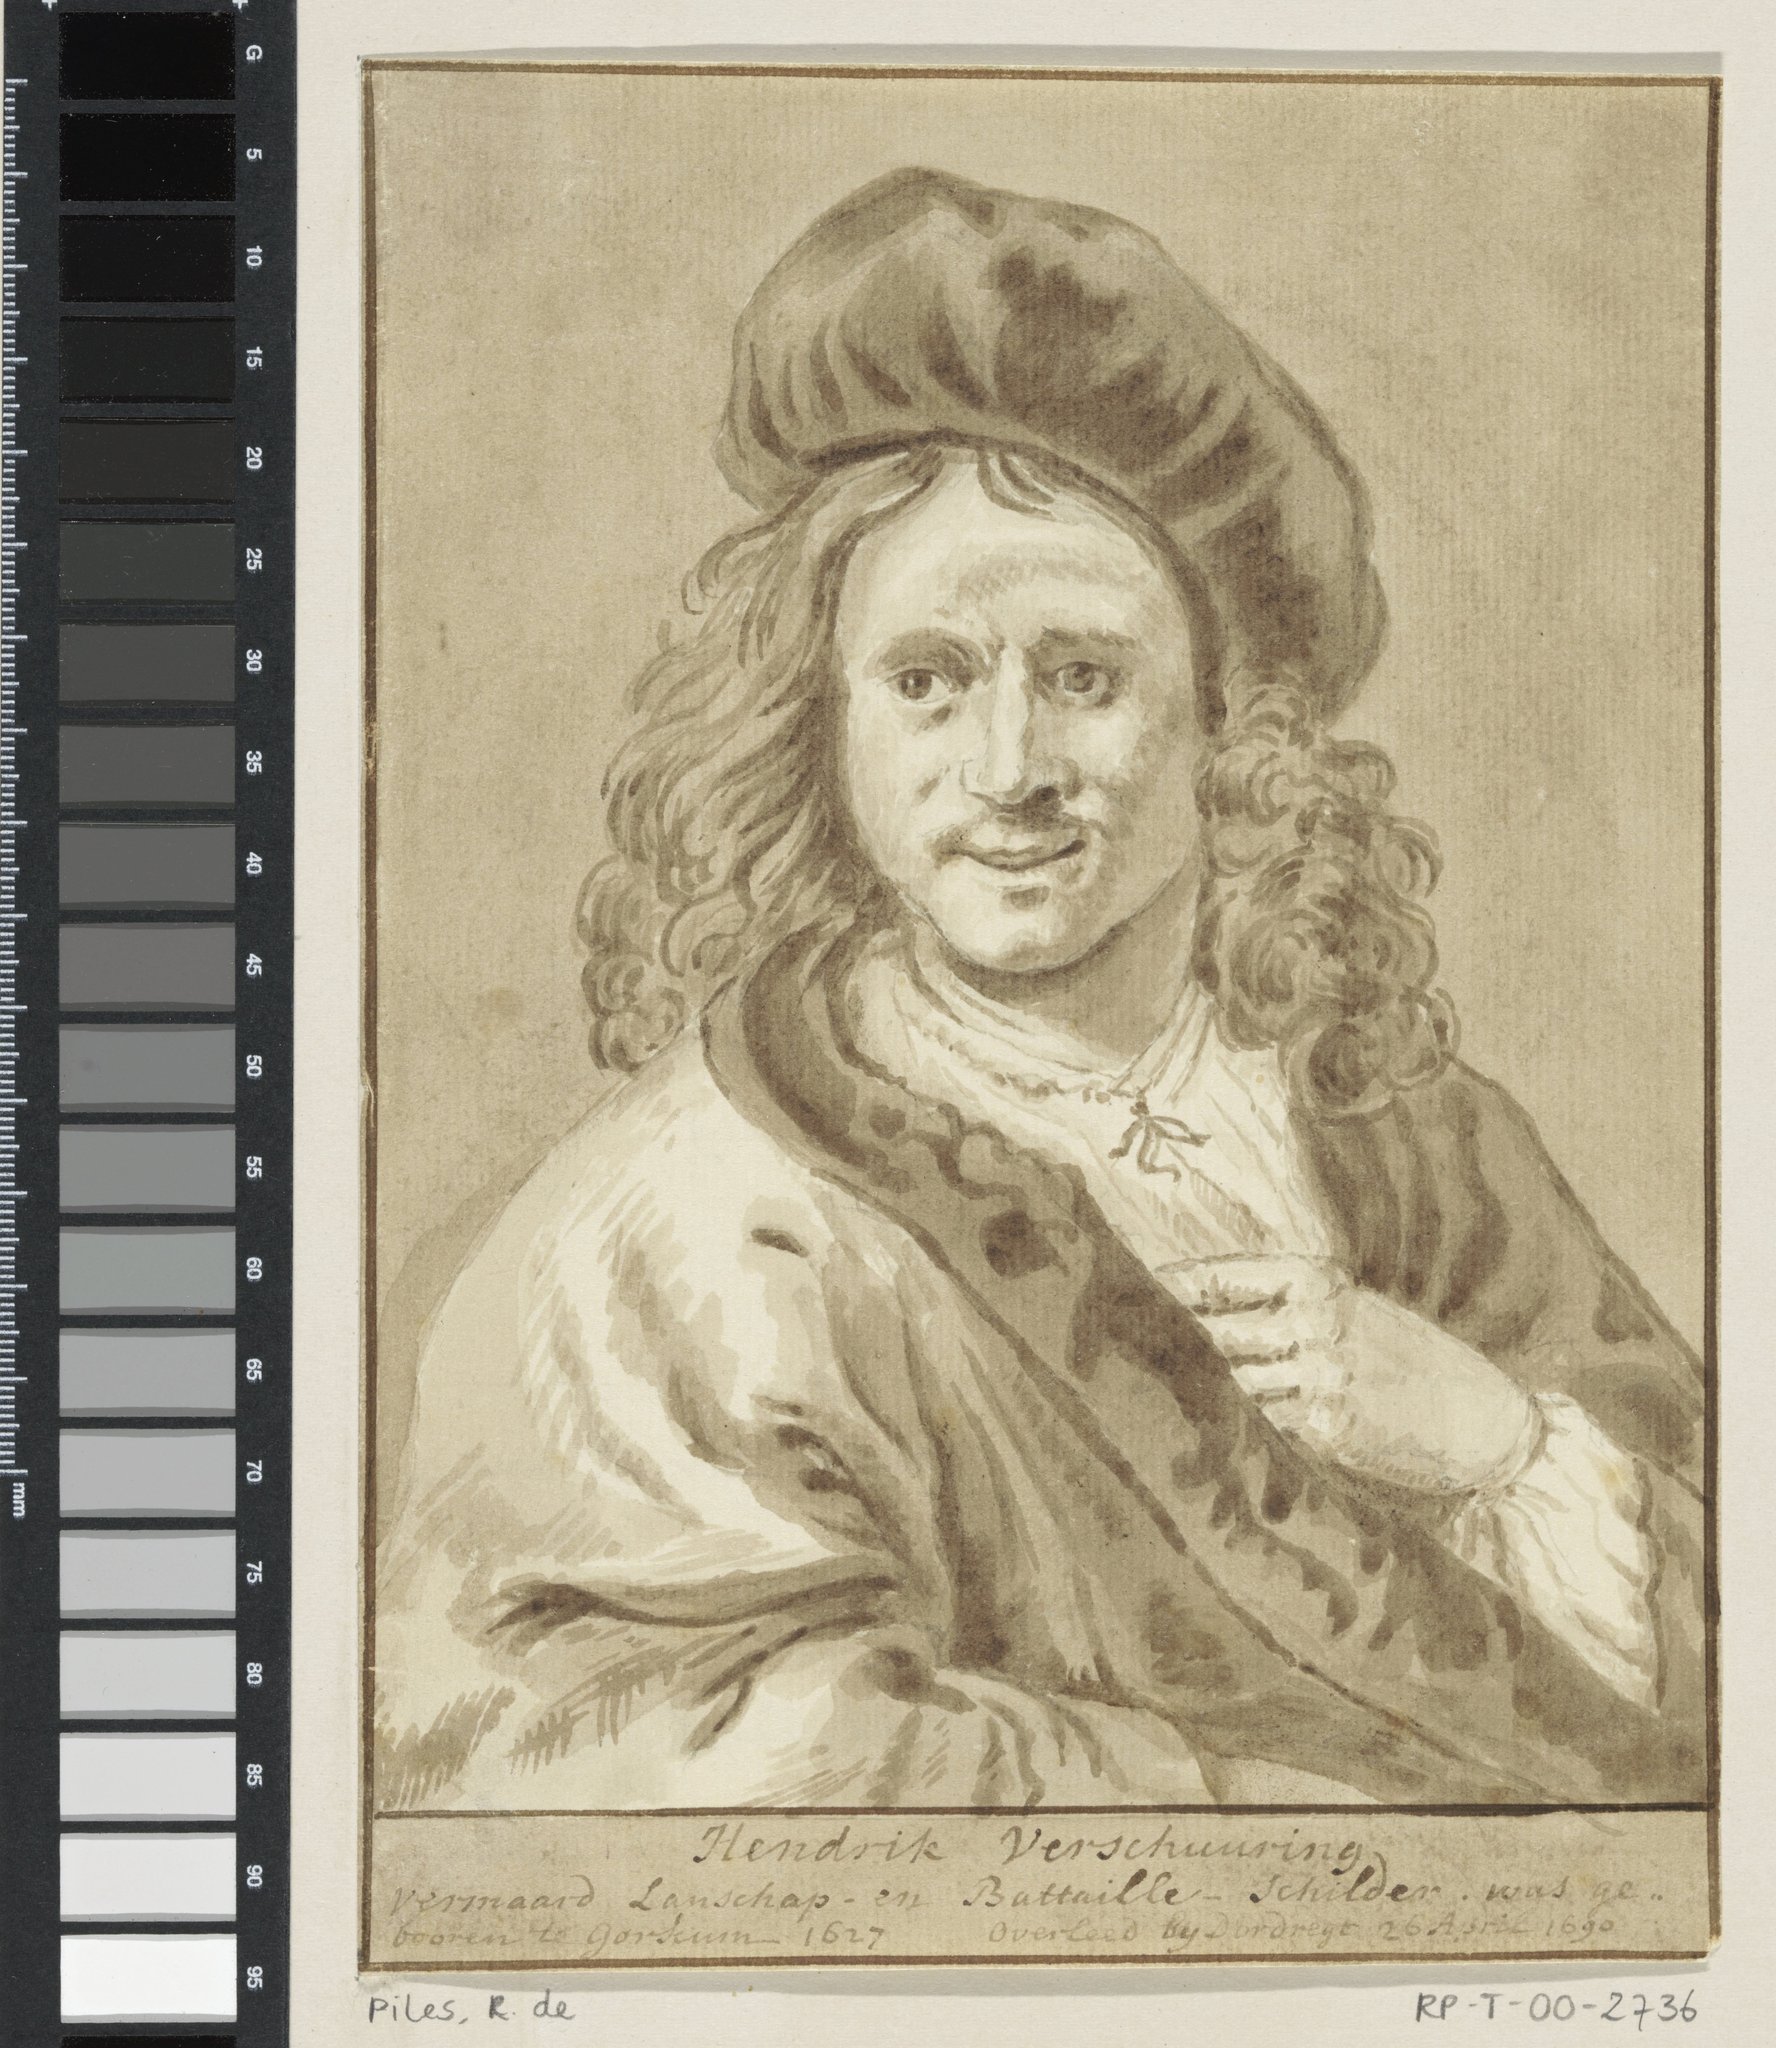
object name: drawing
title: Portret van de schilder Hendrik Verschuring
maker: Anonymous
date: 1766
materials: paper, pencil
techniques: brush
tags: dordrecht, draughtsman, hendrik verschuring, historical persons, portrait, self-portrait of painter, portrait, self-portrait of artist